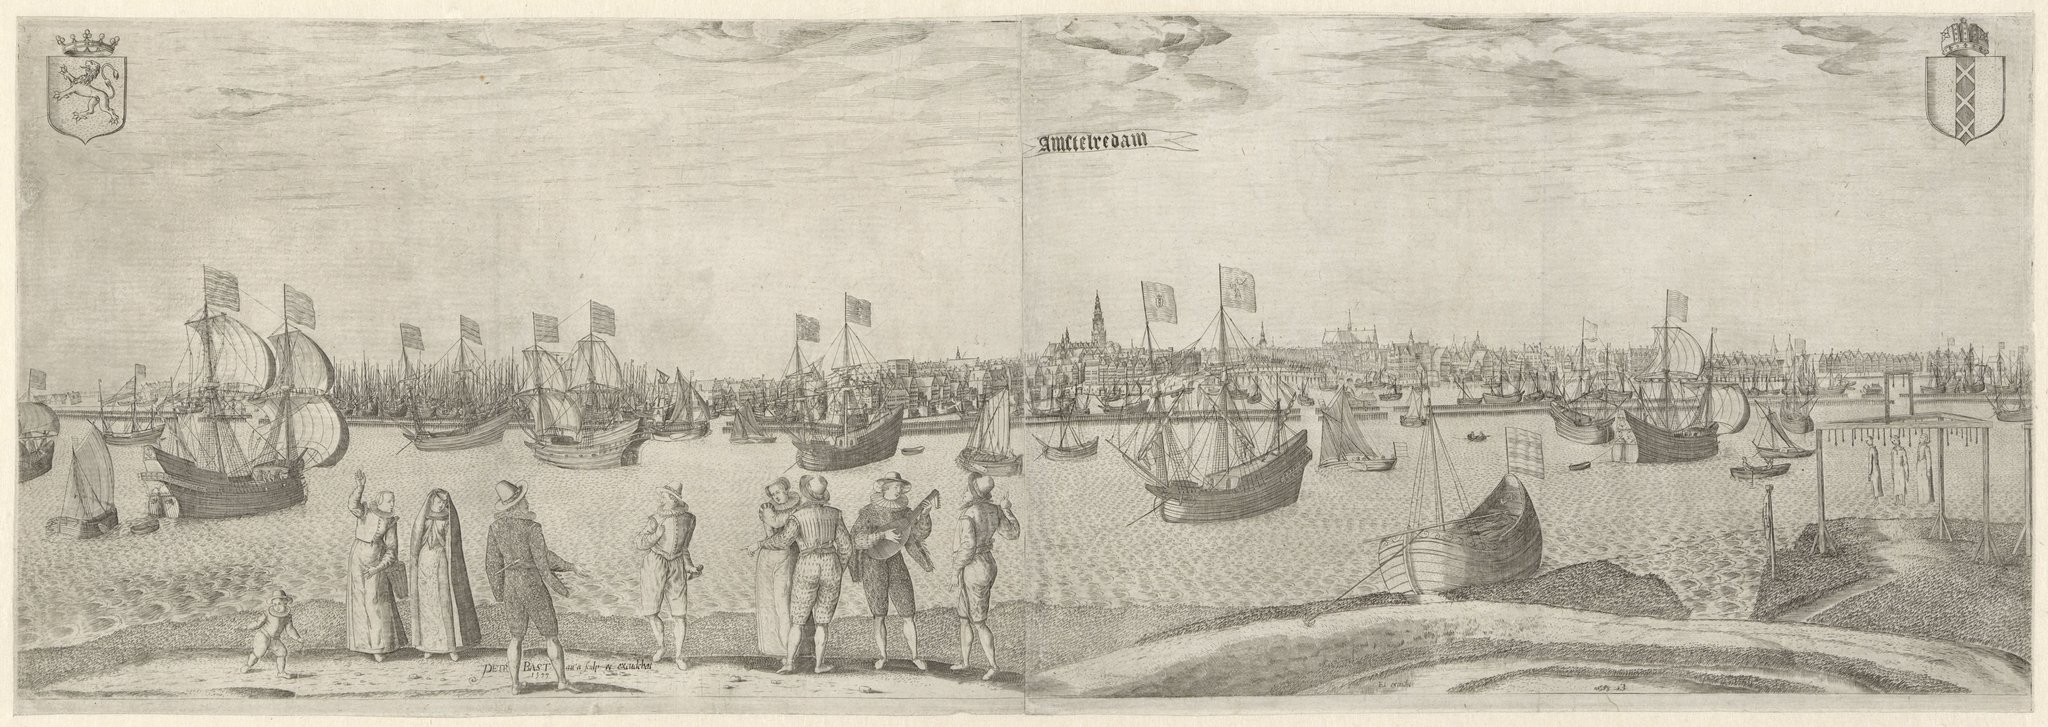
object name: print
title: Gezicht op Amsterdam, gezien vanuit het noorden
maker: pieter bast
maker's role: print maker, publisher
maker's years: 1570-1605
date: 1599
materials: paper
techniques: engraving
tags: harbour, coat of arms (as symbol of the state, etc.) (+ city; municipal), violent death by hanging, ships (in general), coat of arms (as symbol of the state, etc.) (+ province; provincial), prospect of city, town panorama, silhouette of city, lute, and special forms of lute, e.g.: theorbo - cc - out of doors, amsterdam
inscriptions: collector's mark: Lugt 2228, inscription: ‘Meyer 8’, inscription: ‘Pag 91 n 75’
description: In twee bladen om naast elkaâr aaneentevoegen. Op het rechterblad rechts de Volewijk, waar nog 3 lijken van misdadigers aan den galg hangen. In den l.b: op een lint: Amstelredam. In den l.b: het met de keizerskroon gekroonde wapenschild der stad. Op het linksche blad ziet men op den voorgrond een groep van 5 mannen, 3 vrouwen en een knaap. Een der mannen staat op de luit te spelen. In het midden op den grond: Petr. Bast ant et sculp et excudebat en onder de naam: 1599. In den l.b: Het wapen van Holland gedekt met de gravenkroon.